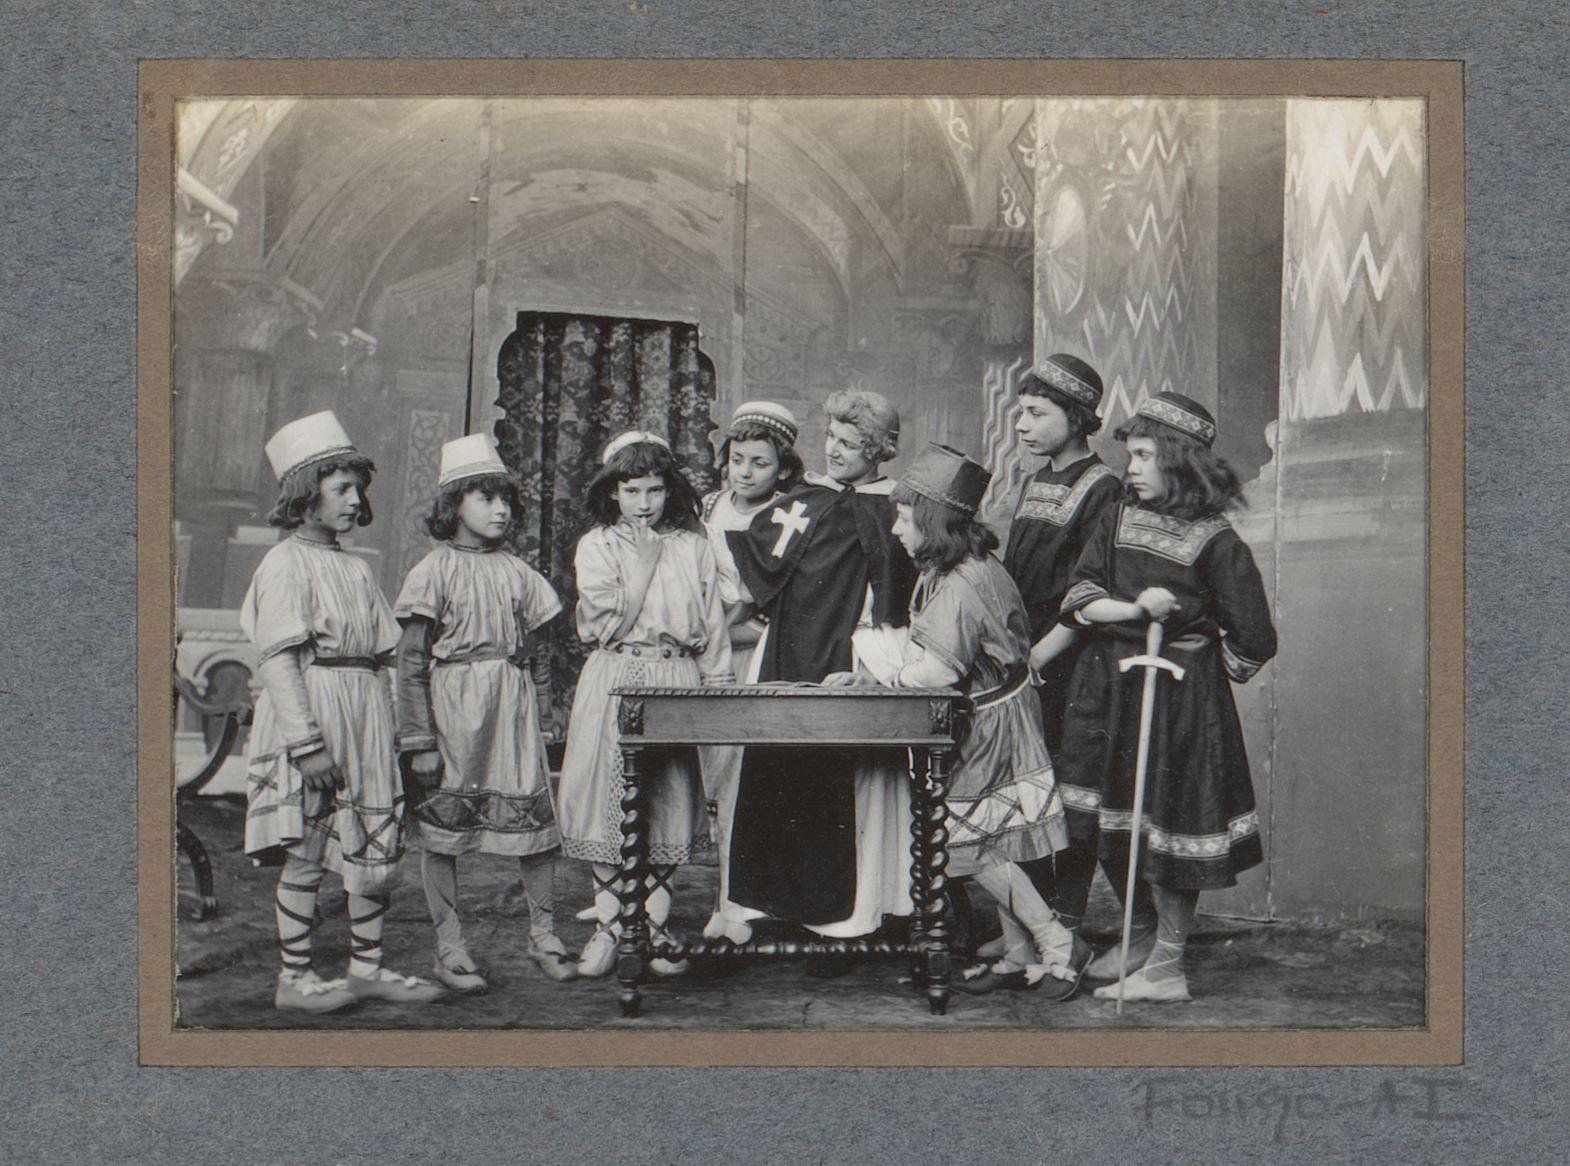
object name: album leaf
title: Kinderen in middeleeuwse theaterdracht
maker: Anonymous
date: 1926-1934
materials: photographic support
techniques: gelatin silver print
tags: theatre, theatrical performance, anonymous historical persons portrayed in a group, in a group-portrait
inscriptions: inscription: ‘Opnamen gemaakt met de "Kodak" Serie III No. 3./ Afdrukken gemaakt op "Velox" papier.’